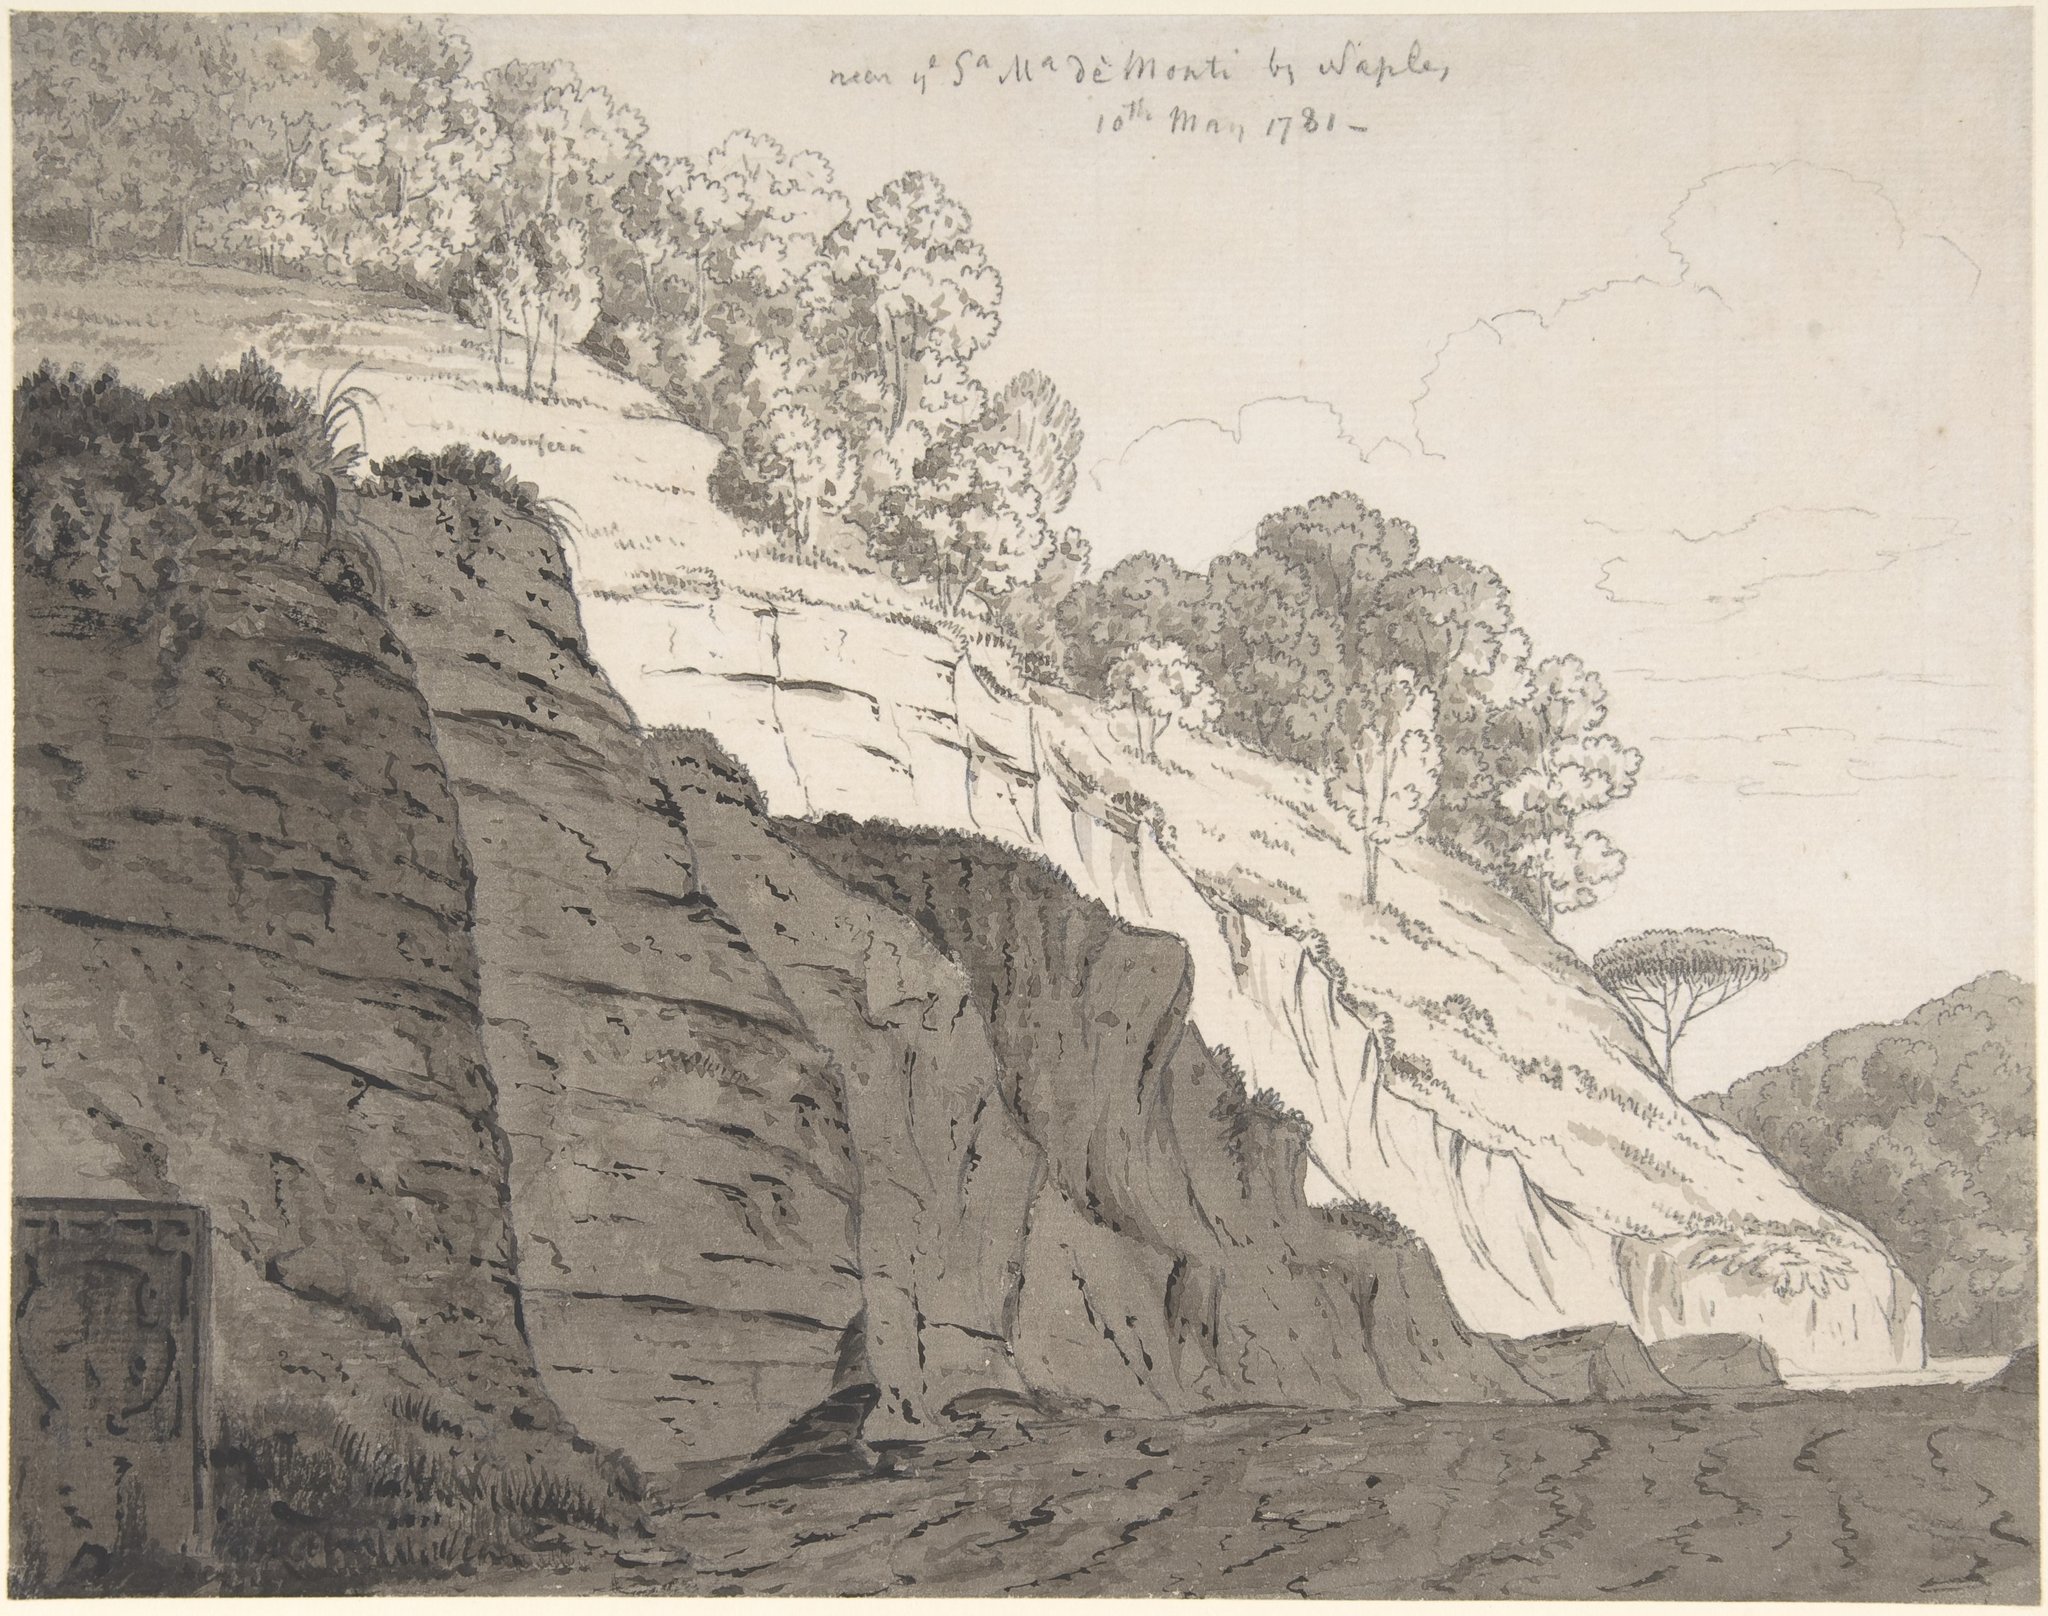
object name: drawing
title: Near Santa Maria de' Monti, Naples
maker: thomas jones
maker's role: artist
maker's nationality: british, welsh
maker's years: 1742-1803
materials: graphite, ink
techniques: brush, wash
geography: italy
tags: mountains,trees